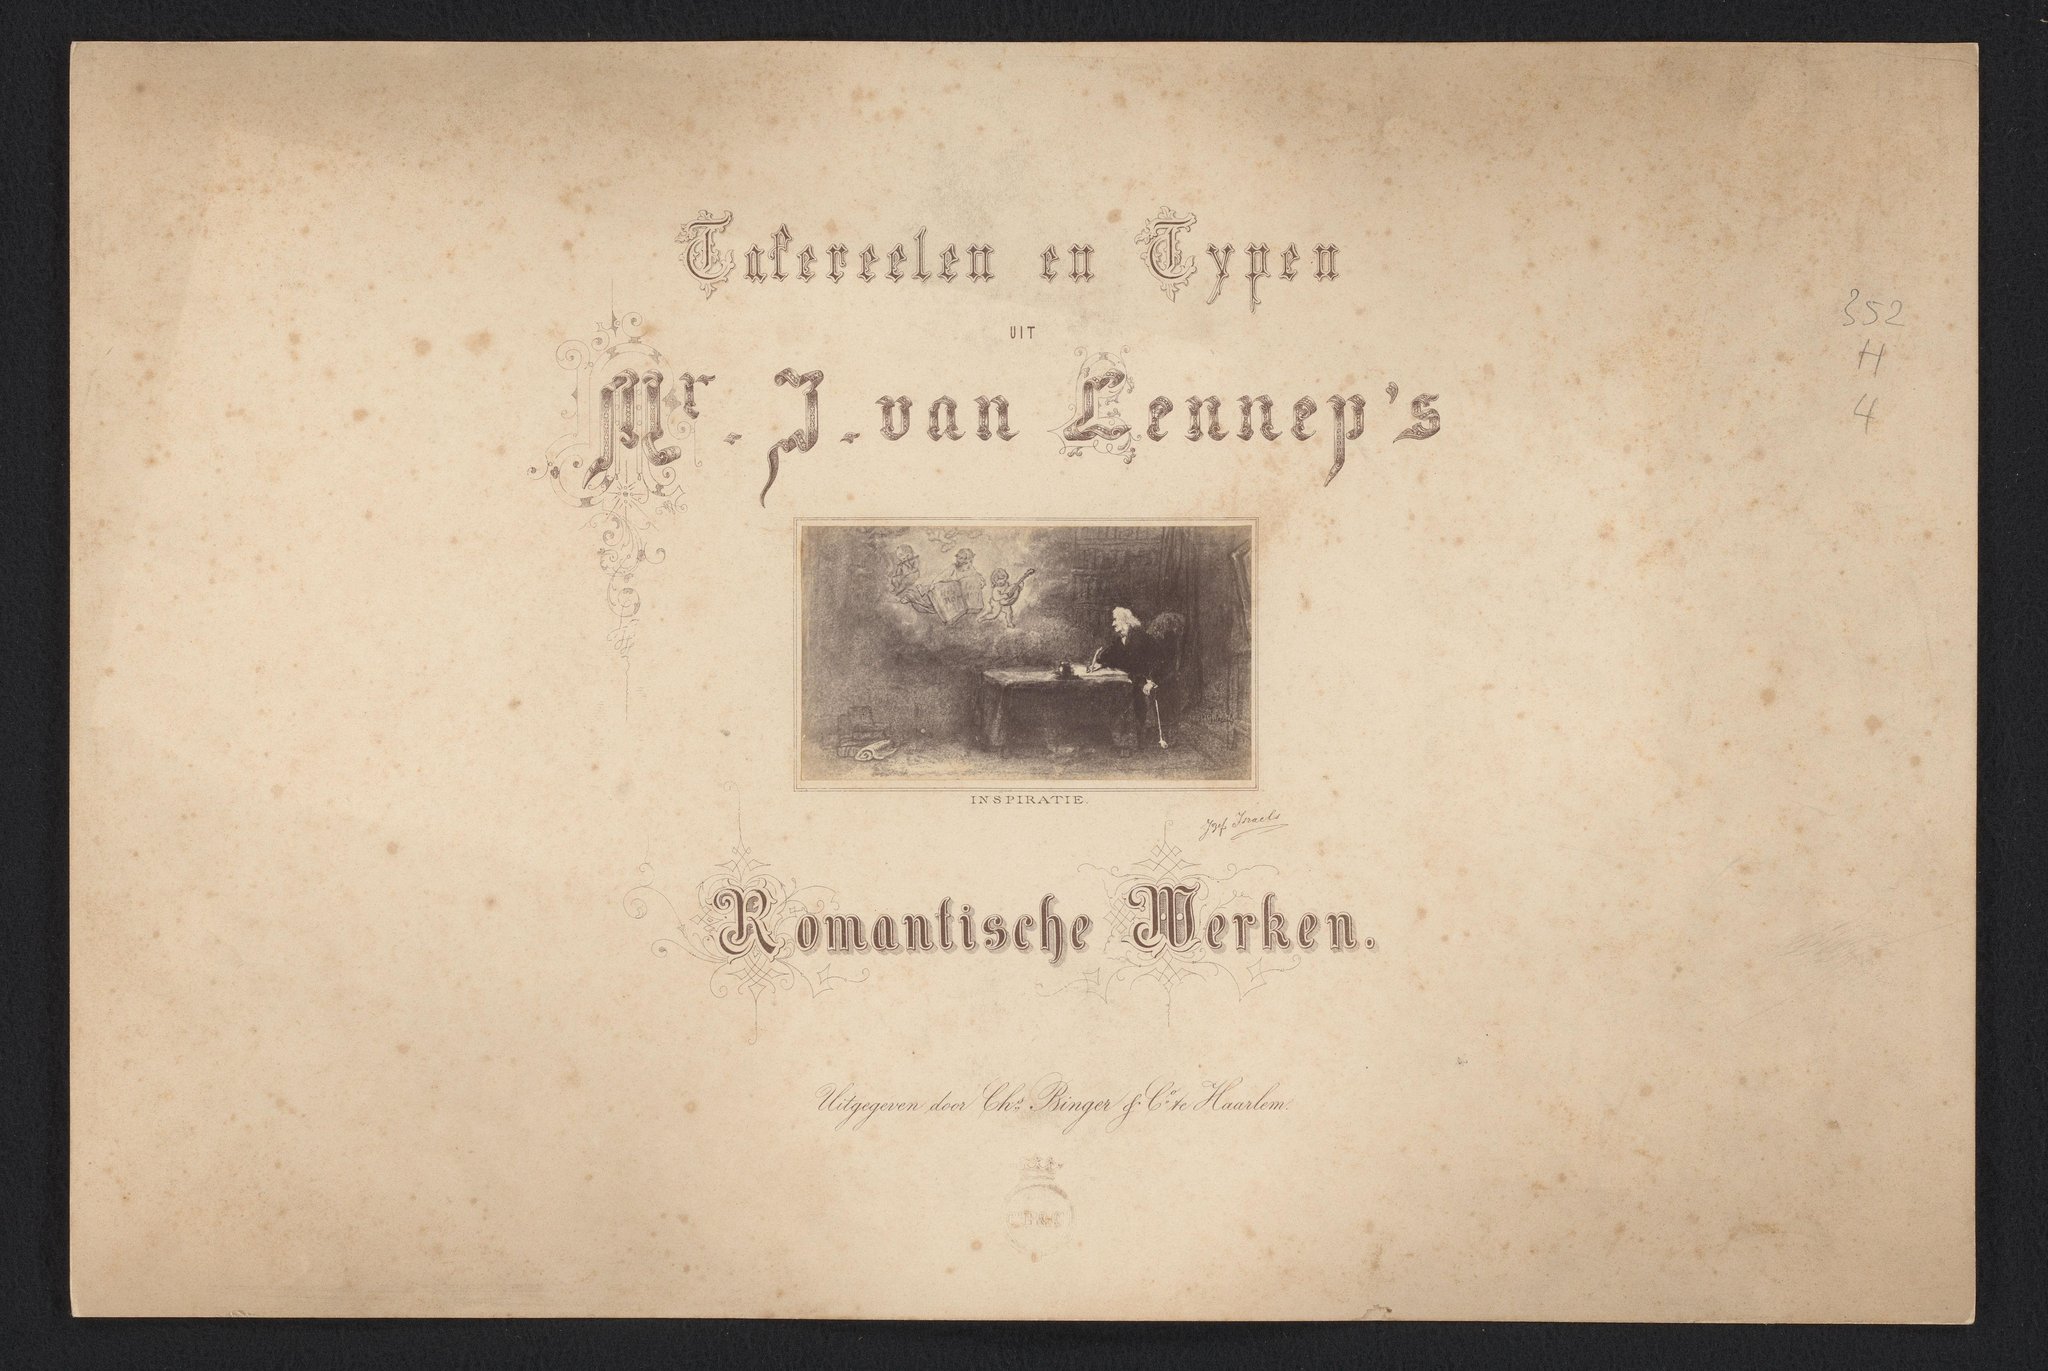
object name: photograph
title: Inspiratie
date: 1865-1870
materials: cardboard, paper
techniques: albumen print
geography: haarlem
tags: amsterdam, jacob van lennep, inspiration of the poet; 'furore poetico' (ripa)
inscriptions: signature: ‘Jozef Israels’, check stamp: ‘Ch. B & C.’